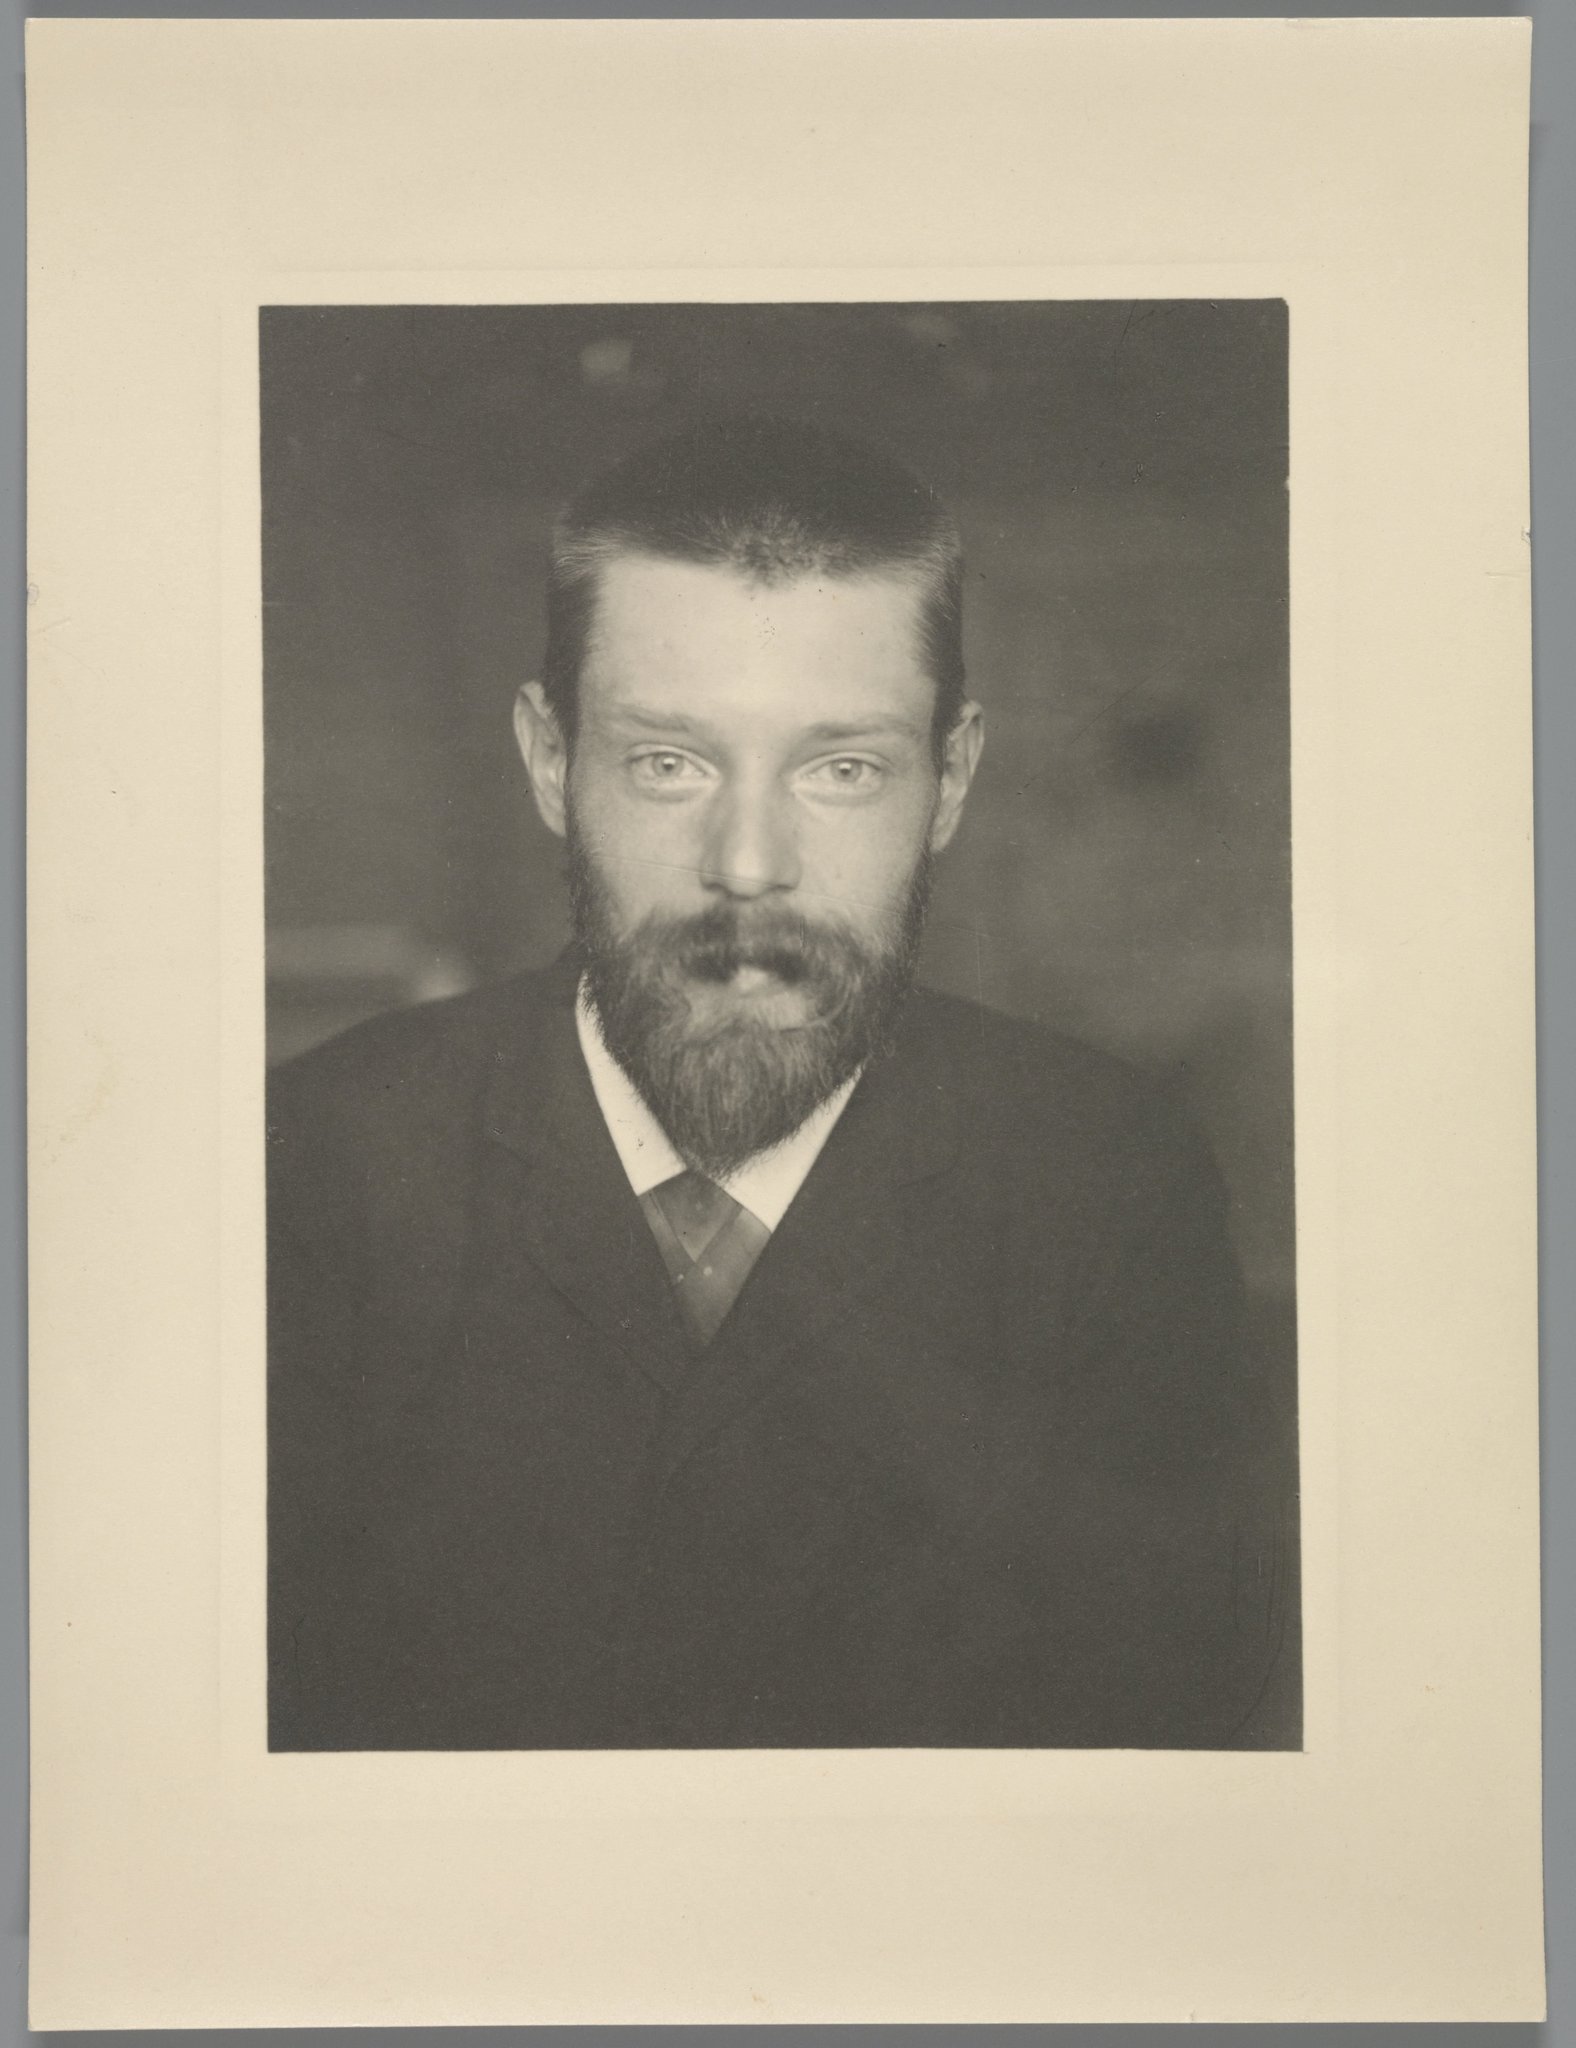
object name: photograph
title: Reproductie naar een foto van Willem Witsen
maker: Anonymous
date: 1860-1915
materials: paper, photographic support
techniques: gelatin silver print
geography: netherlands